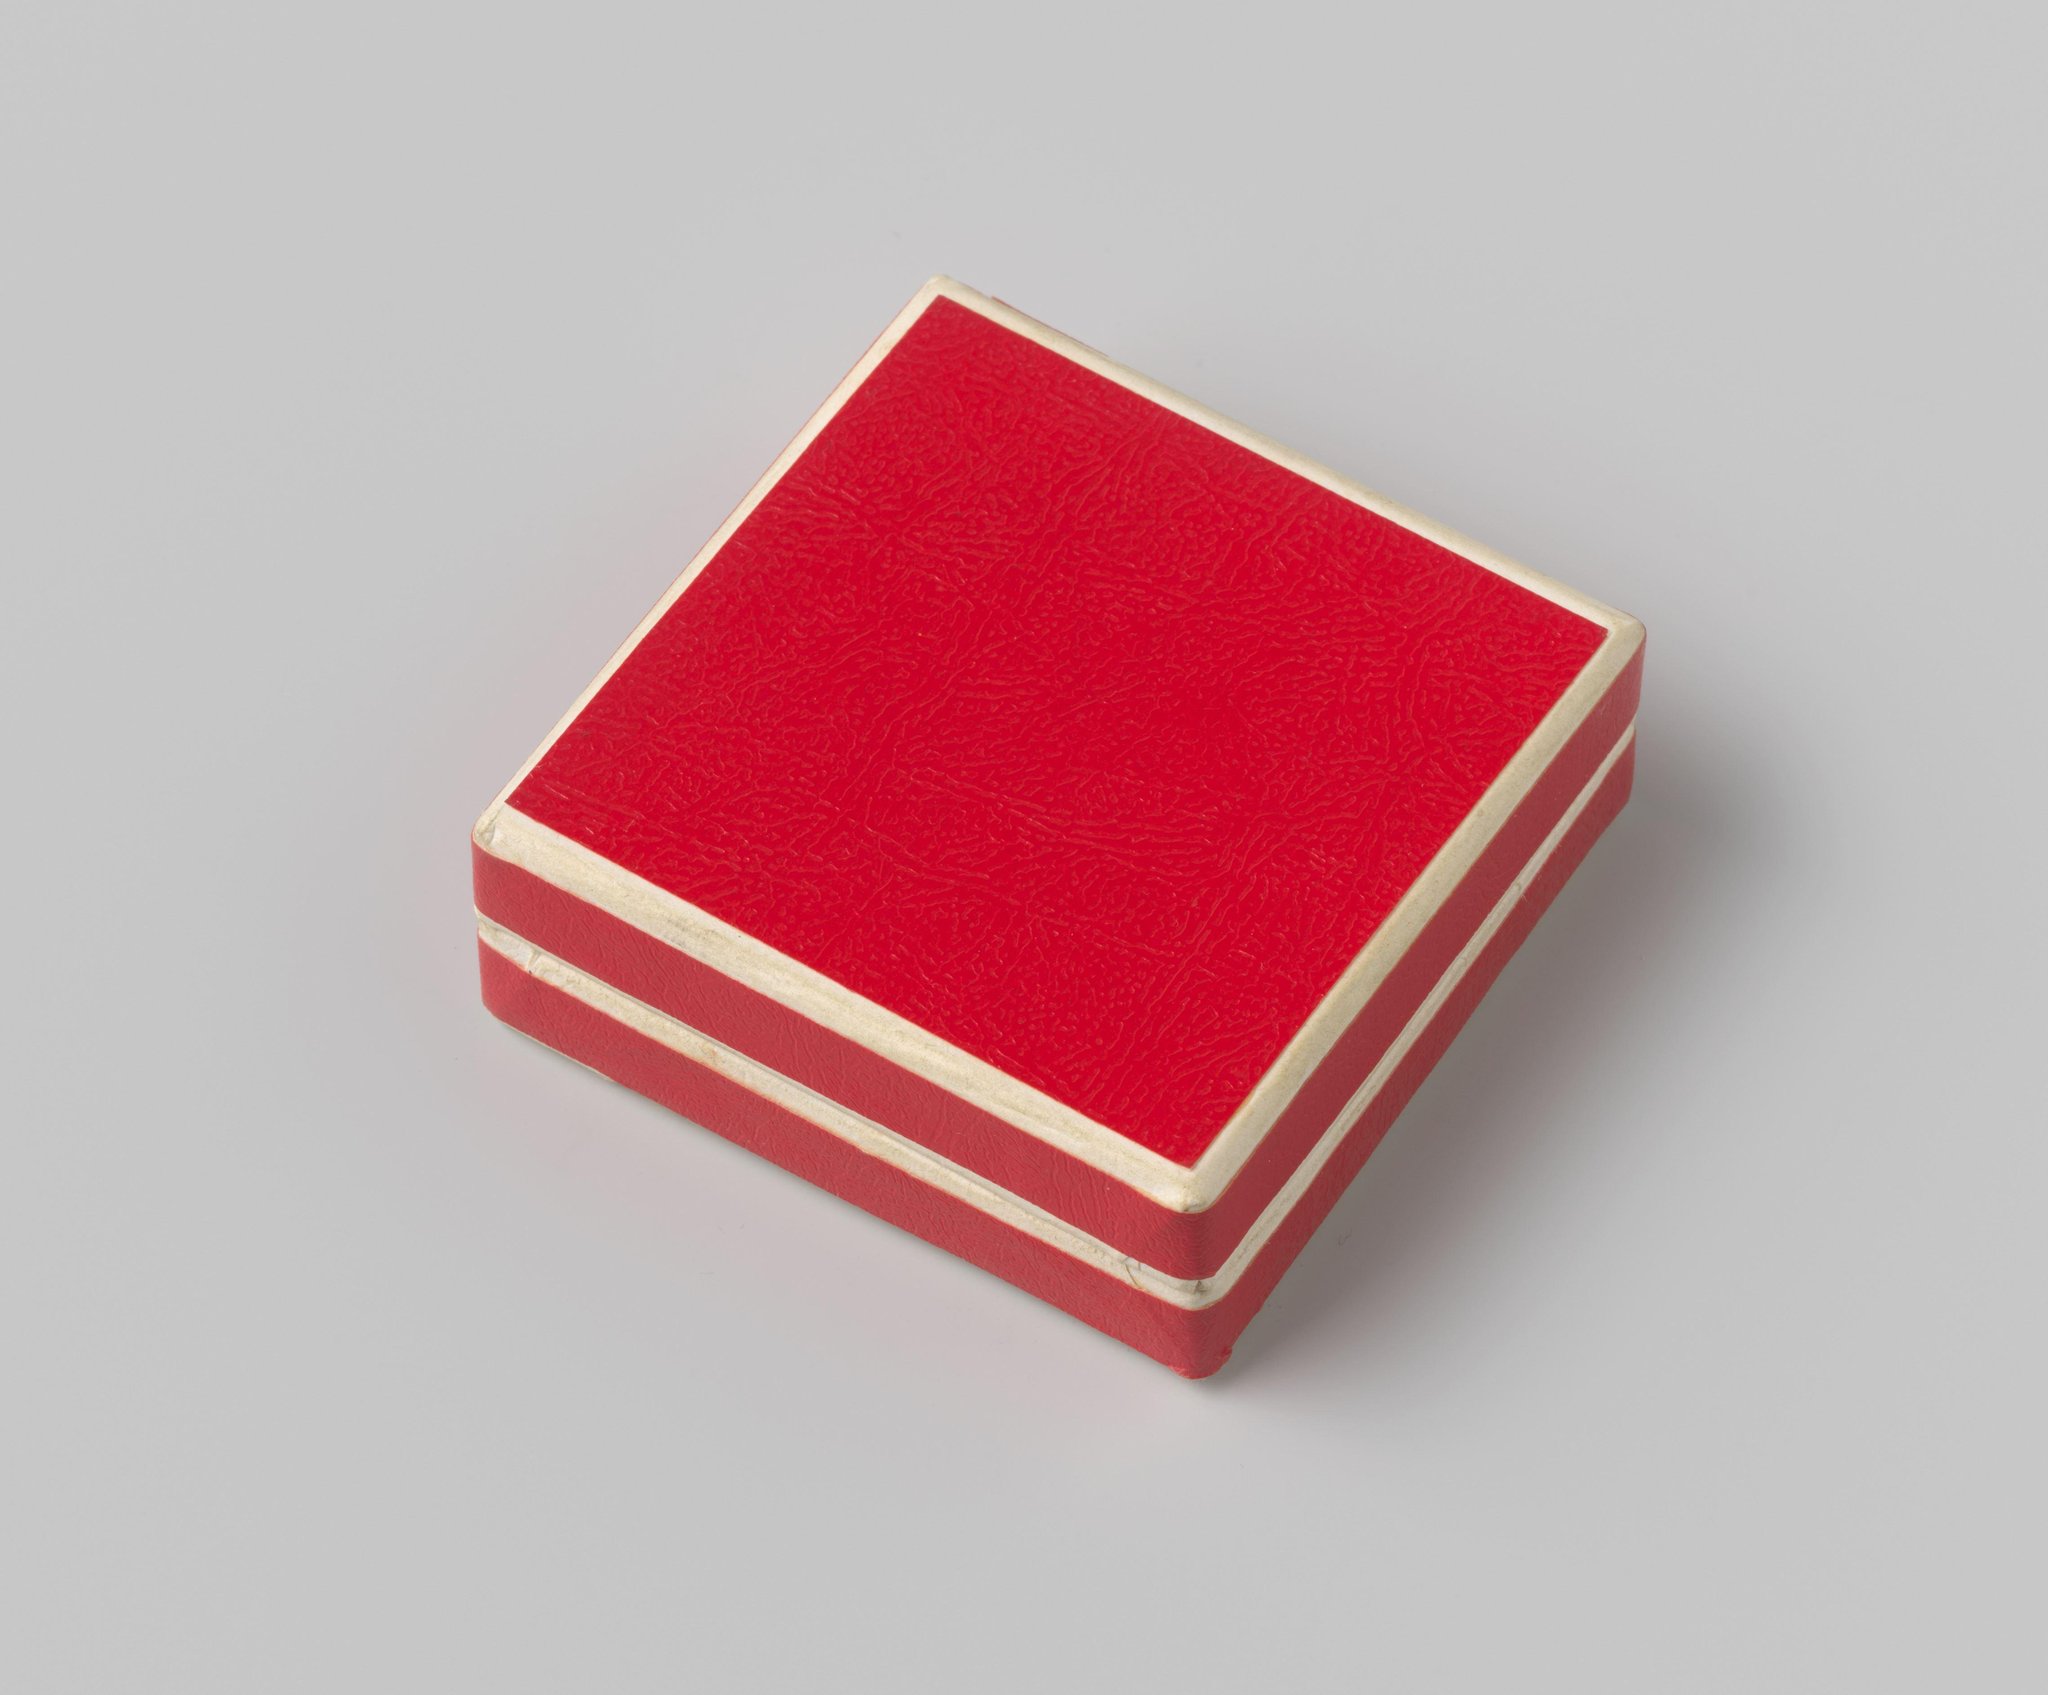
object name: box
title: Rood doosje behorende bij een penning van de vredesestafette van Moskou naar Amsterdam, penning door deelnemers van tocht bij een bezoek aan het Rijksmuseum geschonken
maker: Anonymous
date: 1989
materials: leather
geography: soviet union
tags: brussels, prague, amsterdam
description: Een rood leren doosje met witten randen, behorende bij een penning.